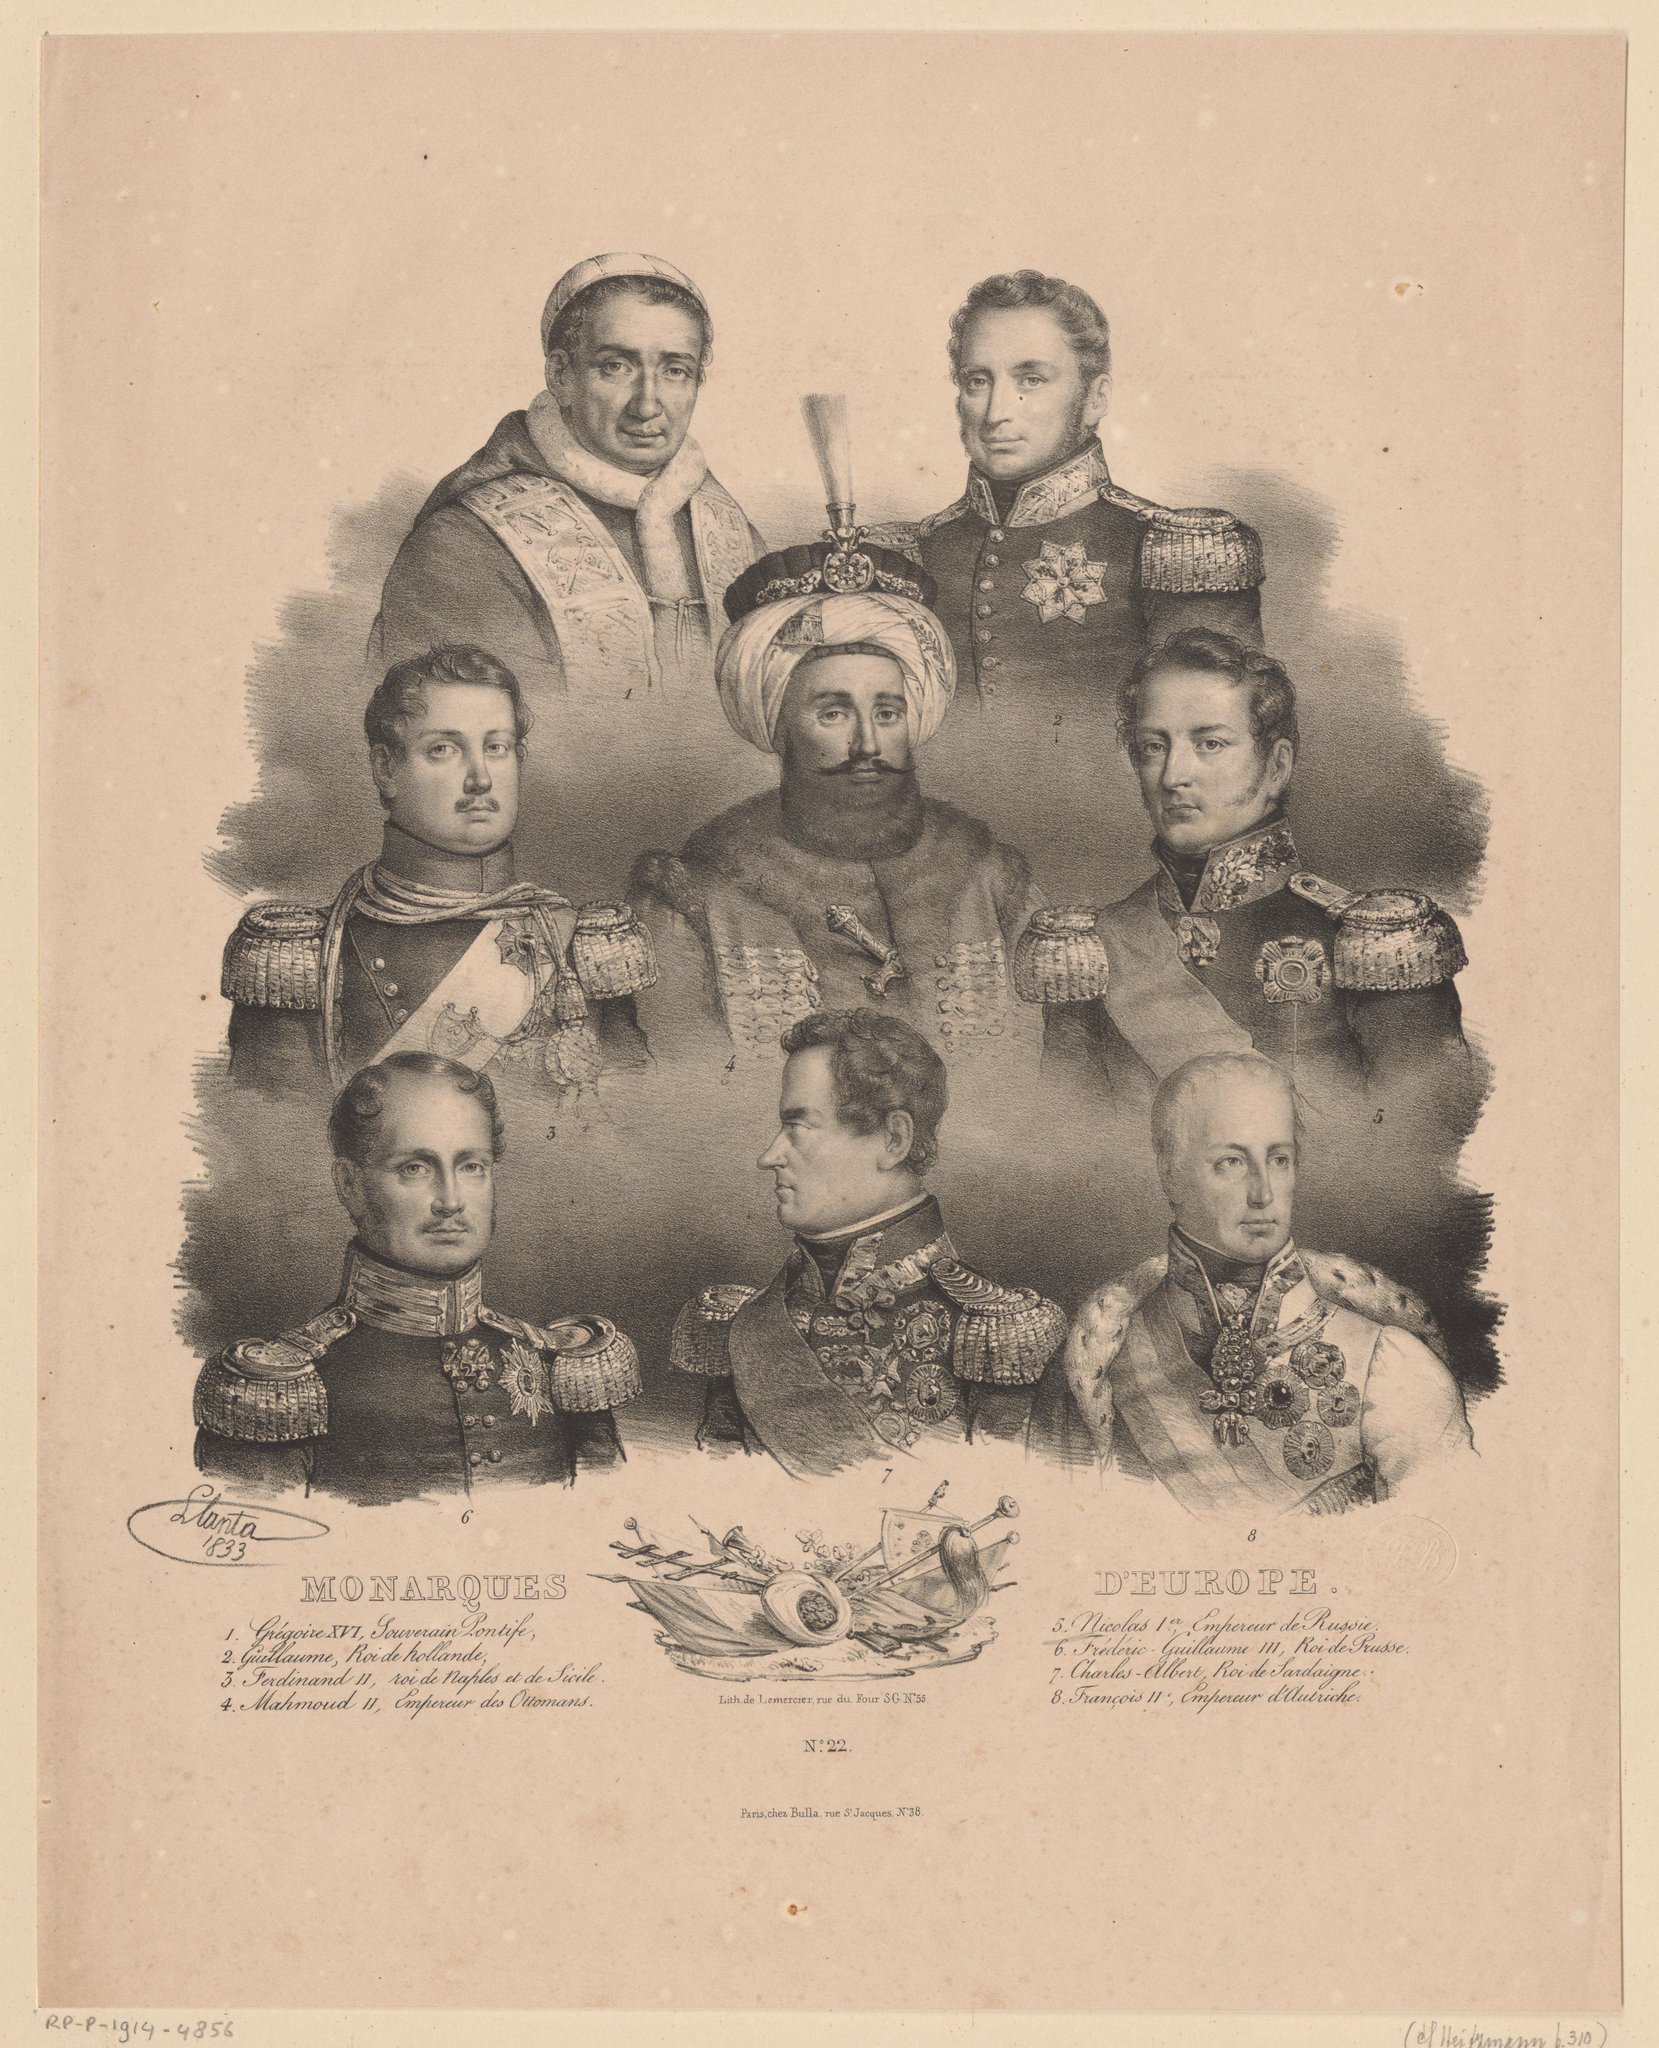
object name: print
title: Portretten van beroemde personen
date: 1833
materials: paper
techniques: lithograph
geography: paris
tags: rome, the hague, william i of the netherlands, frans ii (rooms-duits keizer), berlin, frederik willem iii koning van pruisen, historical persons, ruler, sovereign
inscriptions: collector's mark: Lugt 2228, check stamp: Lugt 4088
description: Portretten van paus Gregorius XVI, Willem I (koning der Nederlanden), Ferdinand II (koning der Beide Siciliën), Mahmut II (sultan van het Ottomaanse Rijk), Nicolaas I Pavlovitsj (tsaar van Rusland), Frederik Willem III (koning van Pruisen), Karel Albert (koning van Sardinië) en Frans II (Rooms-Duits keizer).